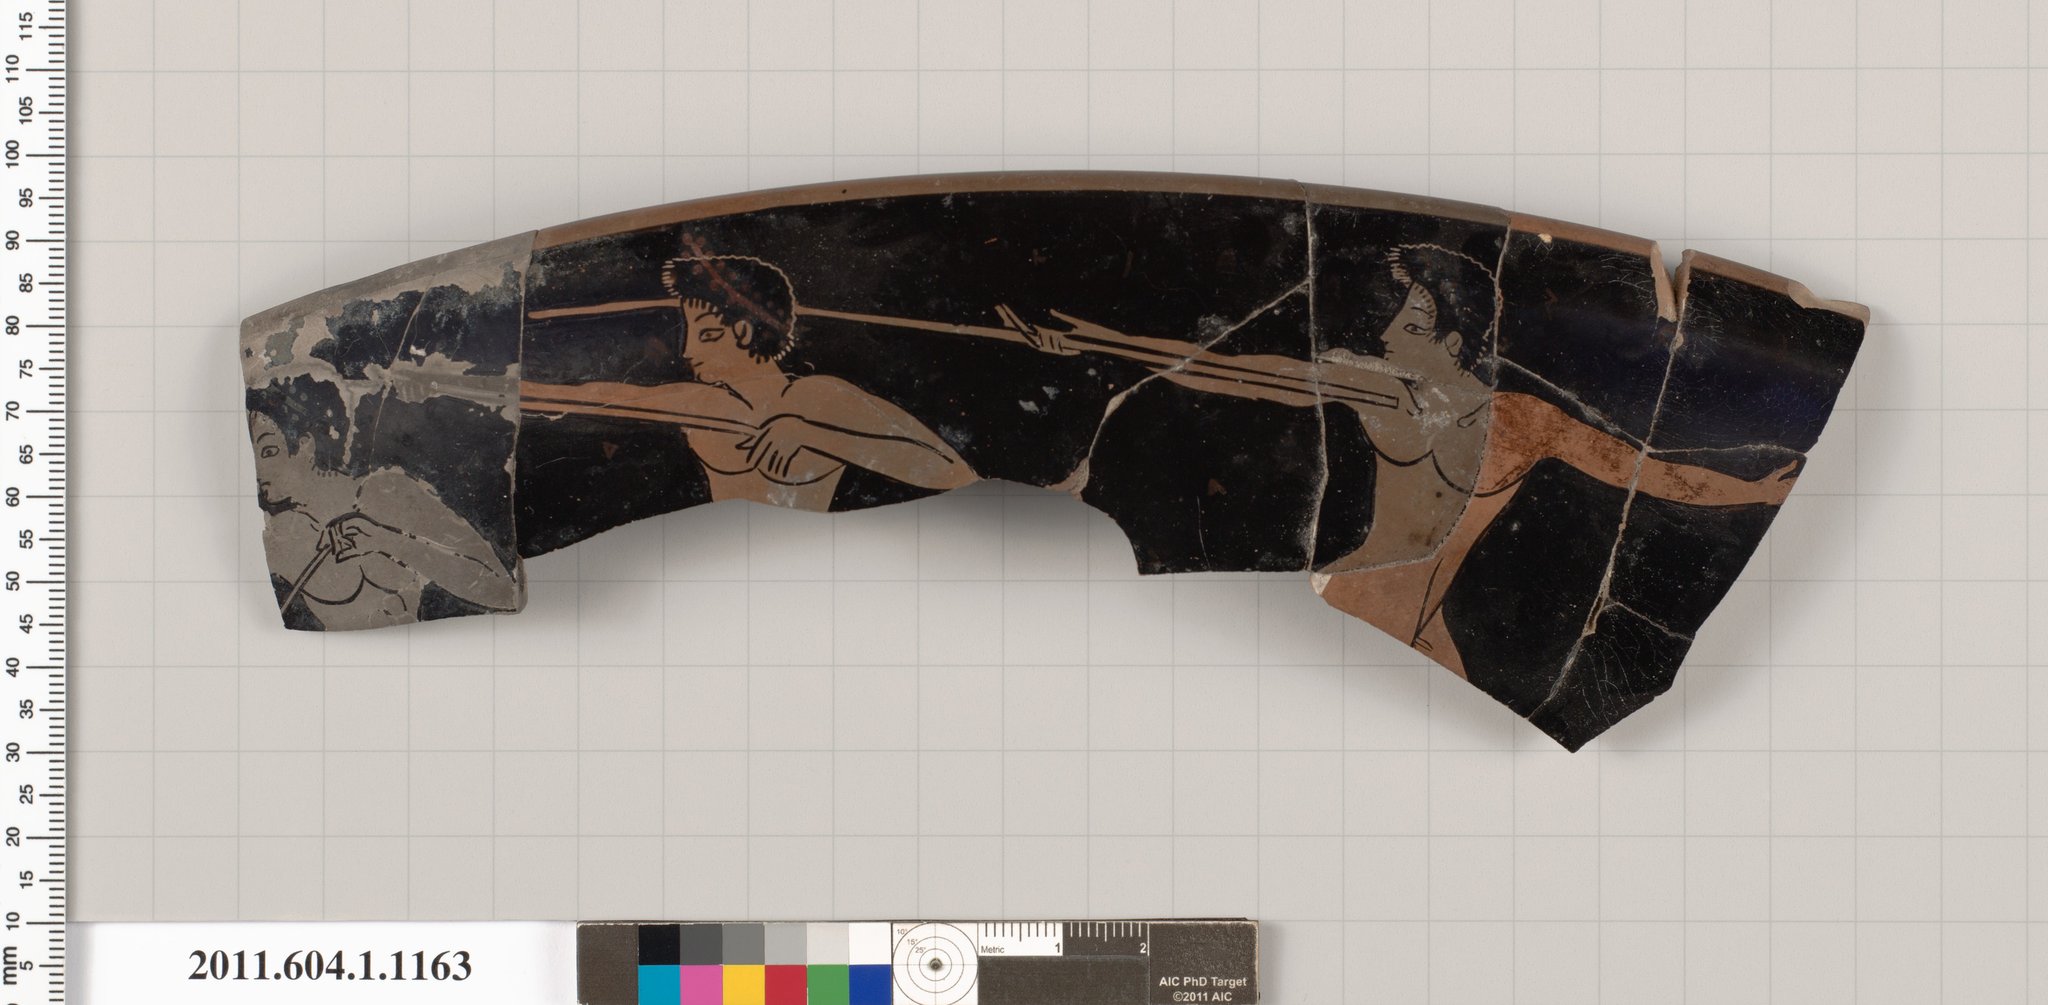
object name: kylix fragment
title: Terracotta fragment of a kylix (drinking cup)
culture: greek, attic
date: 520-500 BCE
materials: terracotta